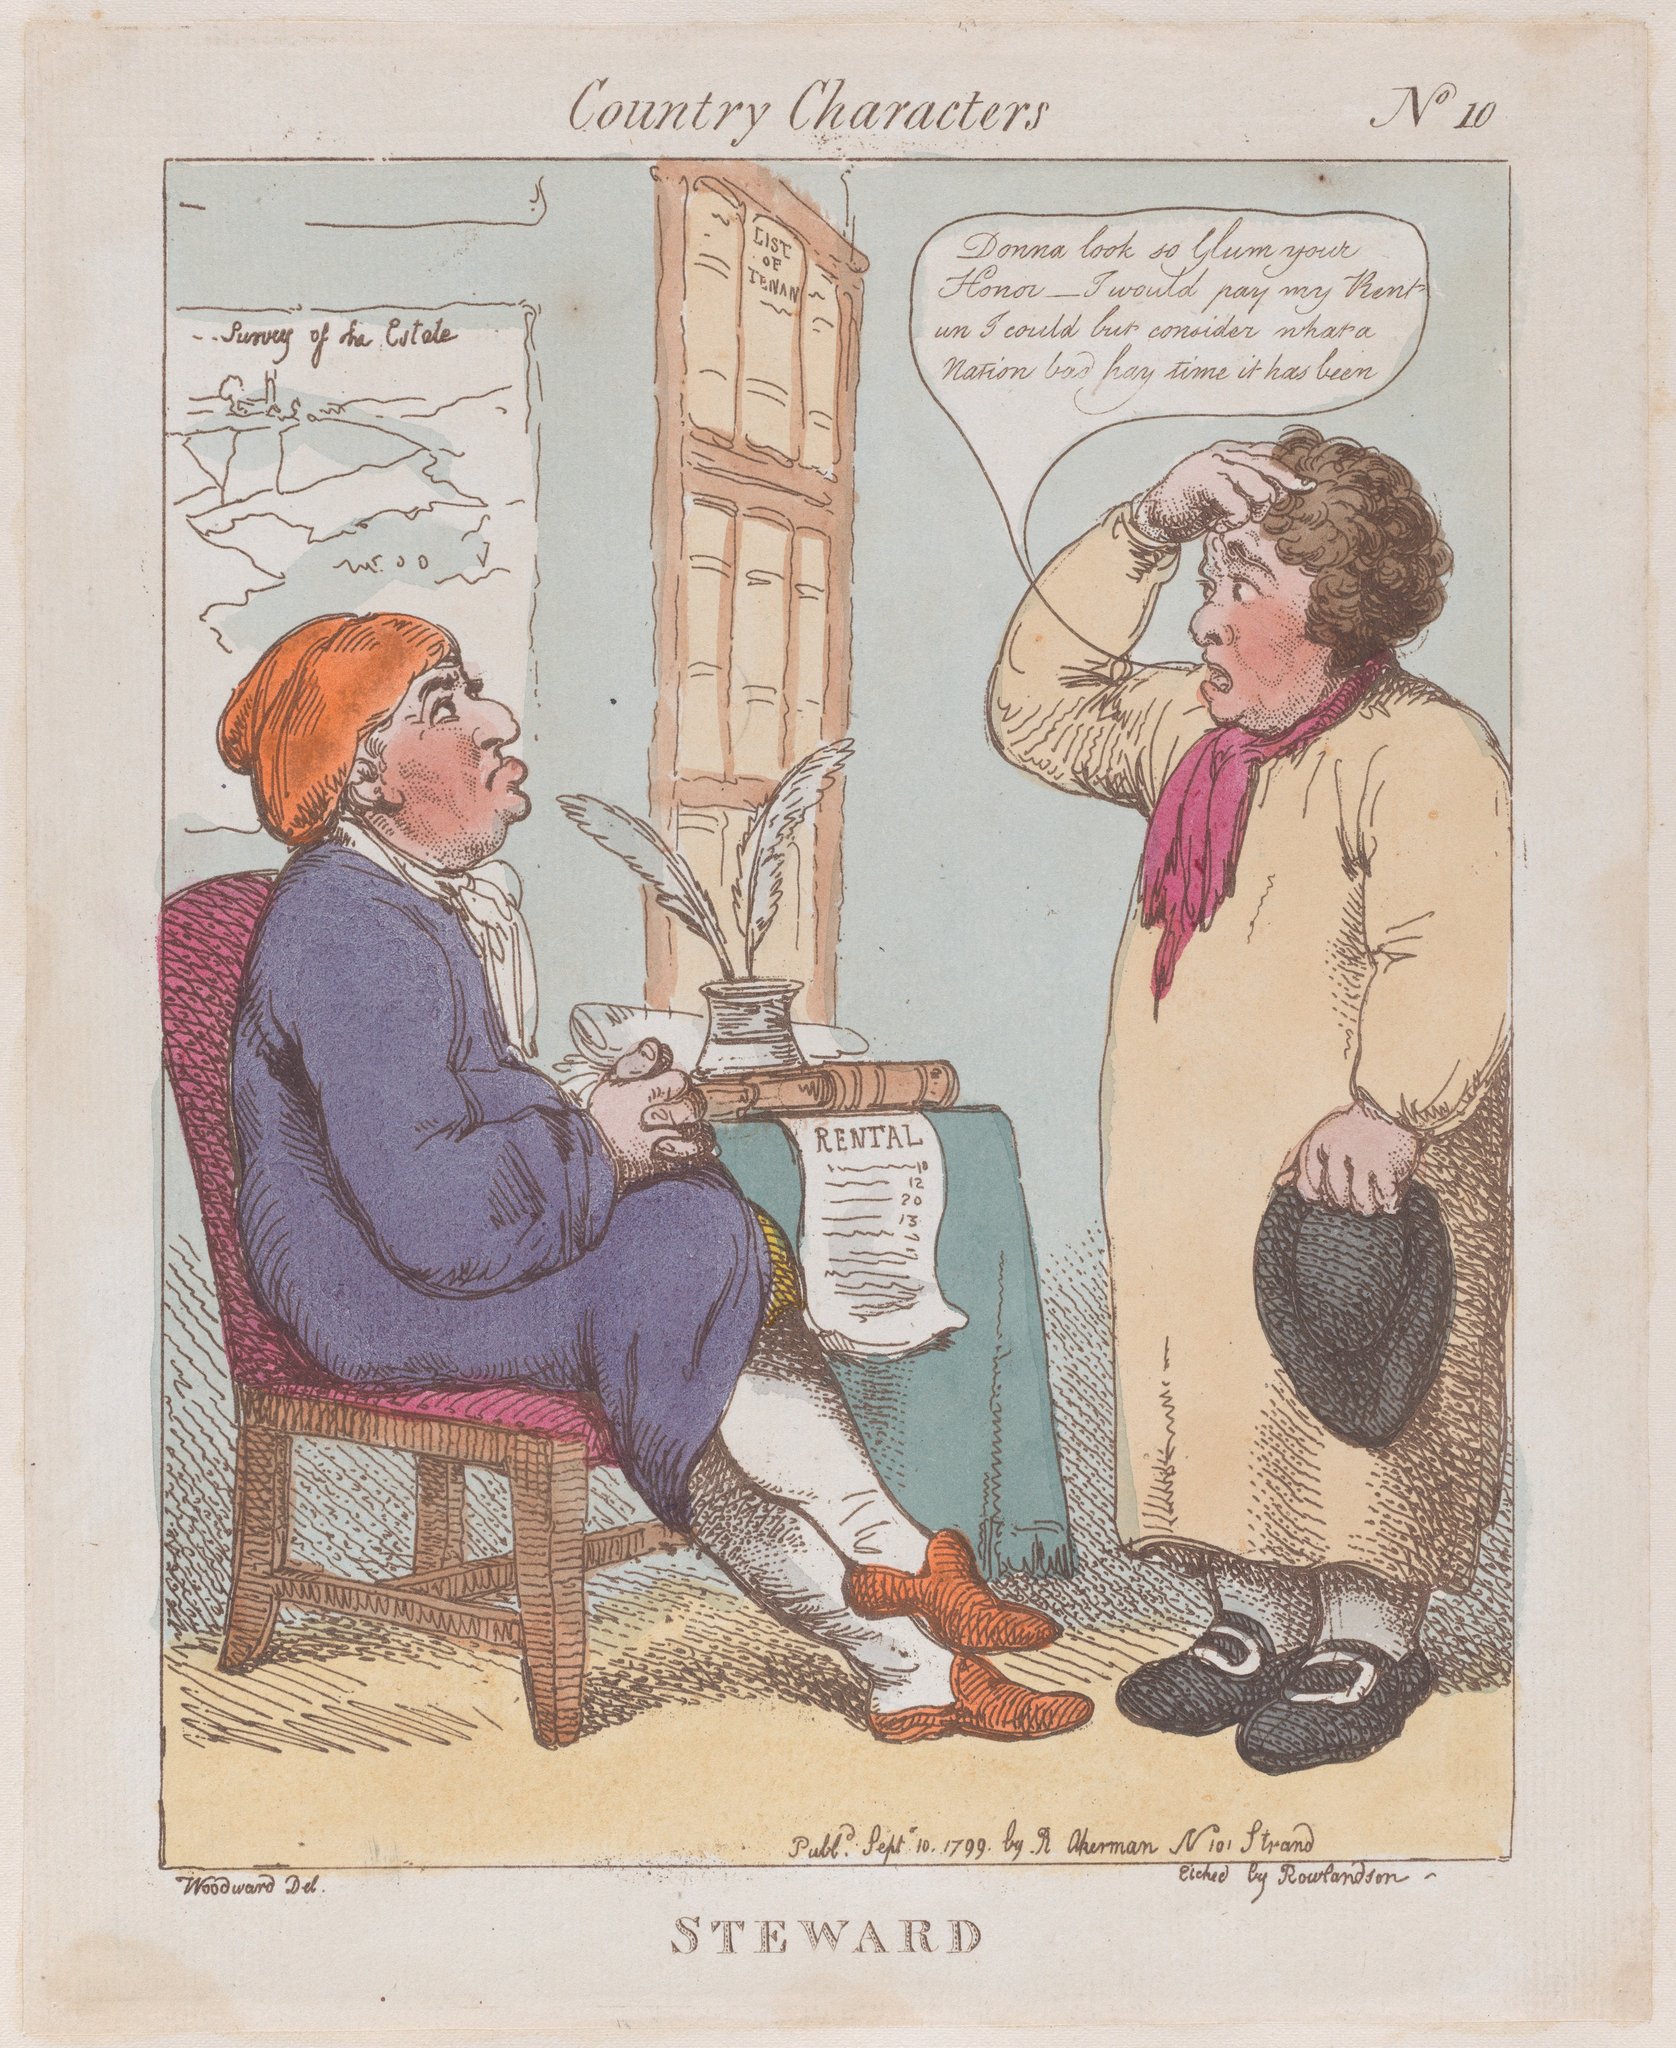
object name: print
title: Steward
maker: thomas rowlandson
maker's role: artist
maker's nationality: british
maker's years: 1757-1827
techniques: etching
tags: satire,men